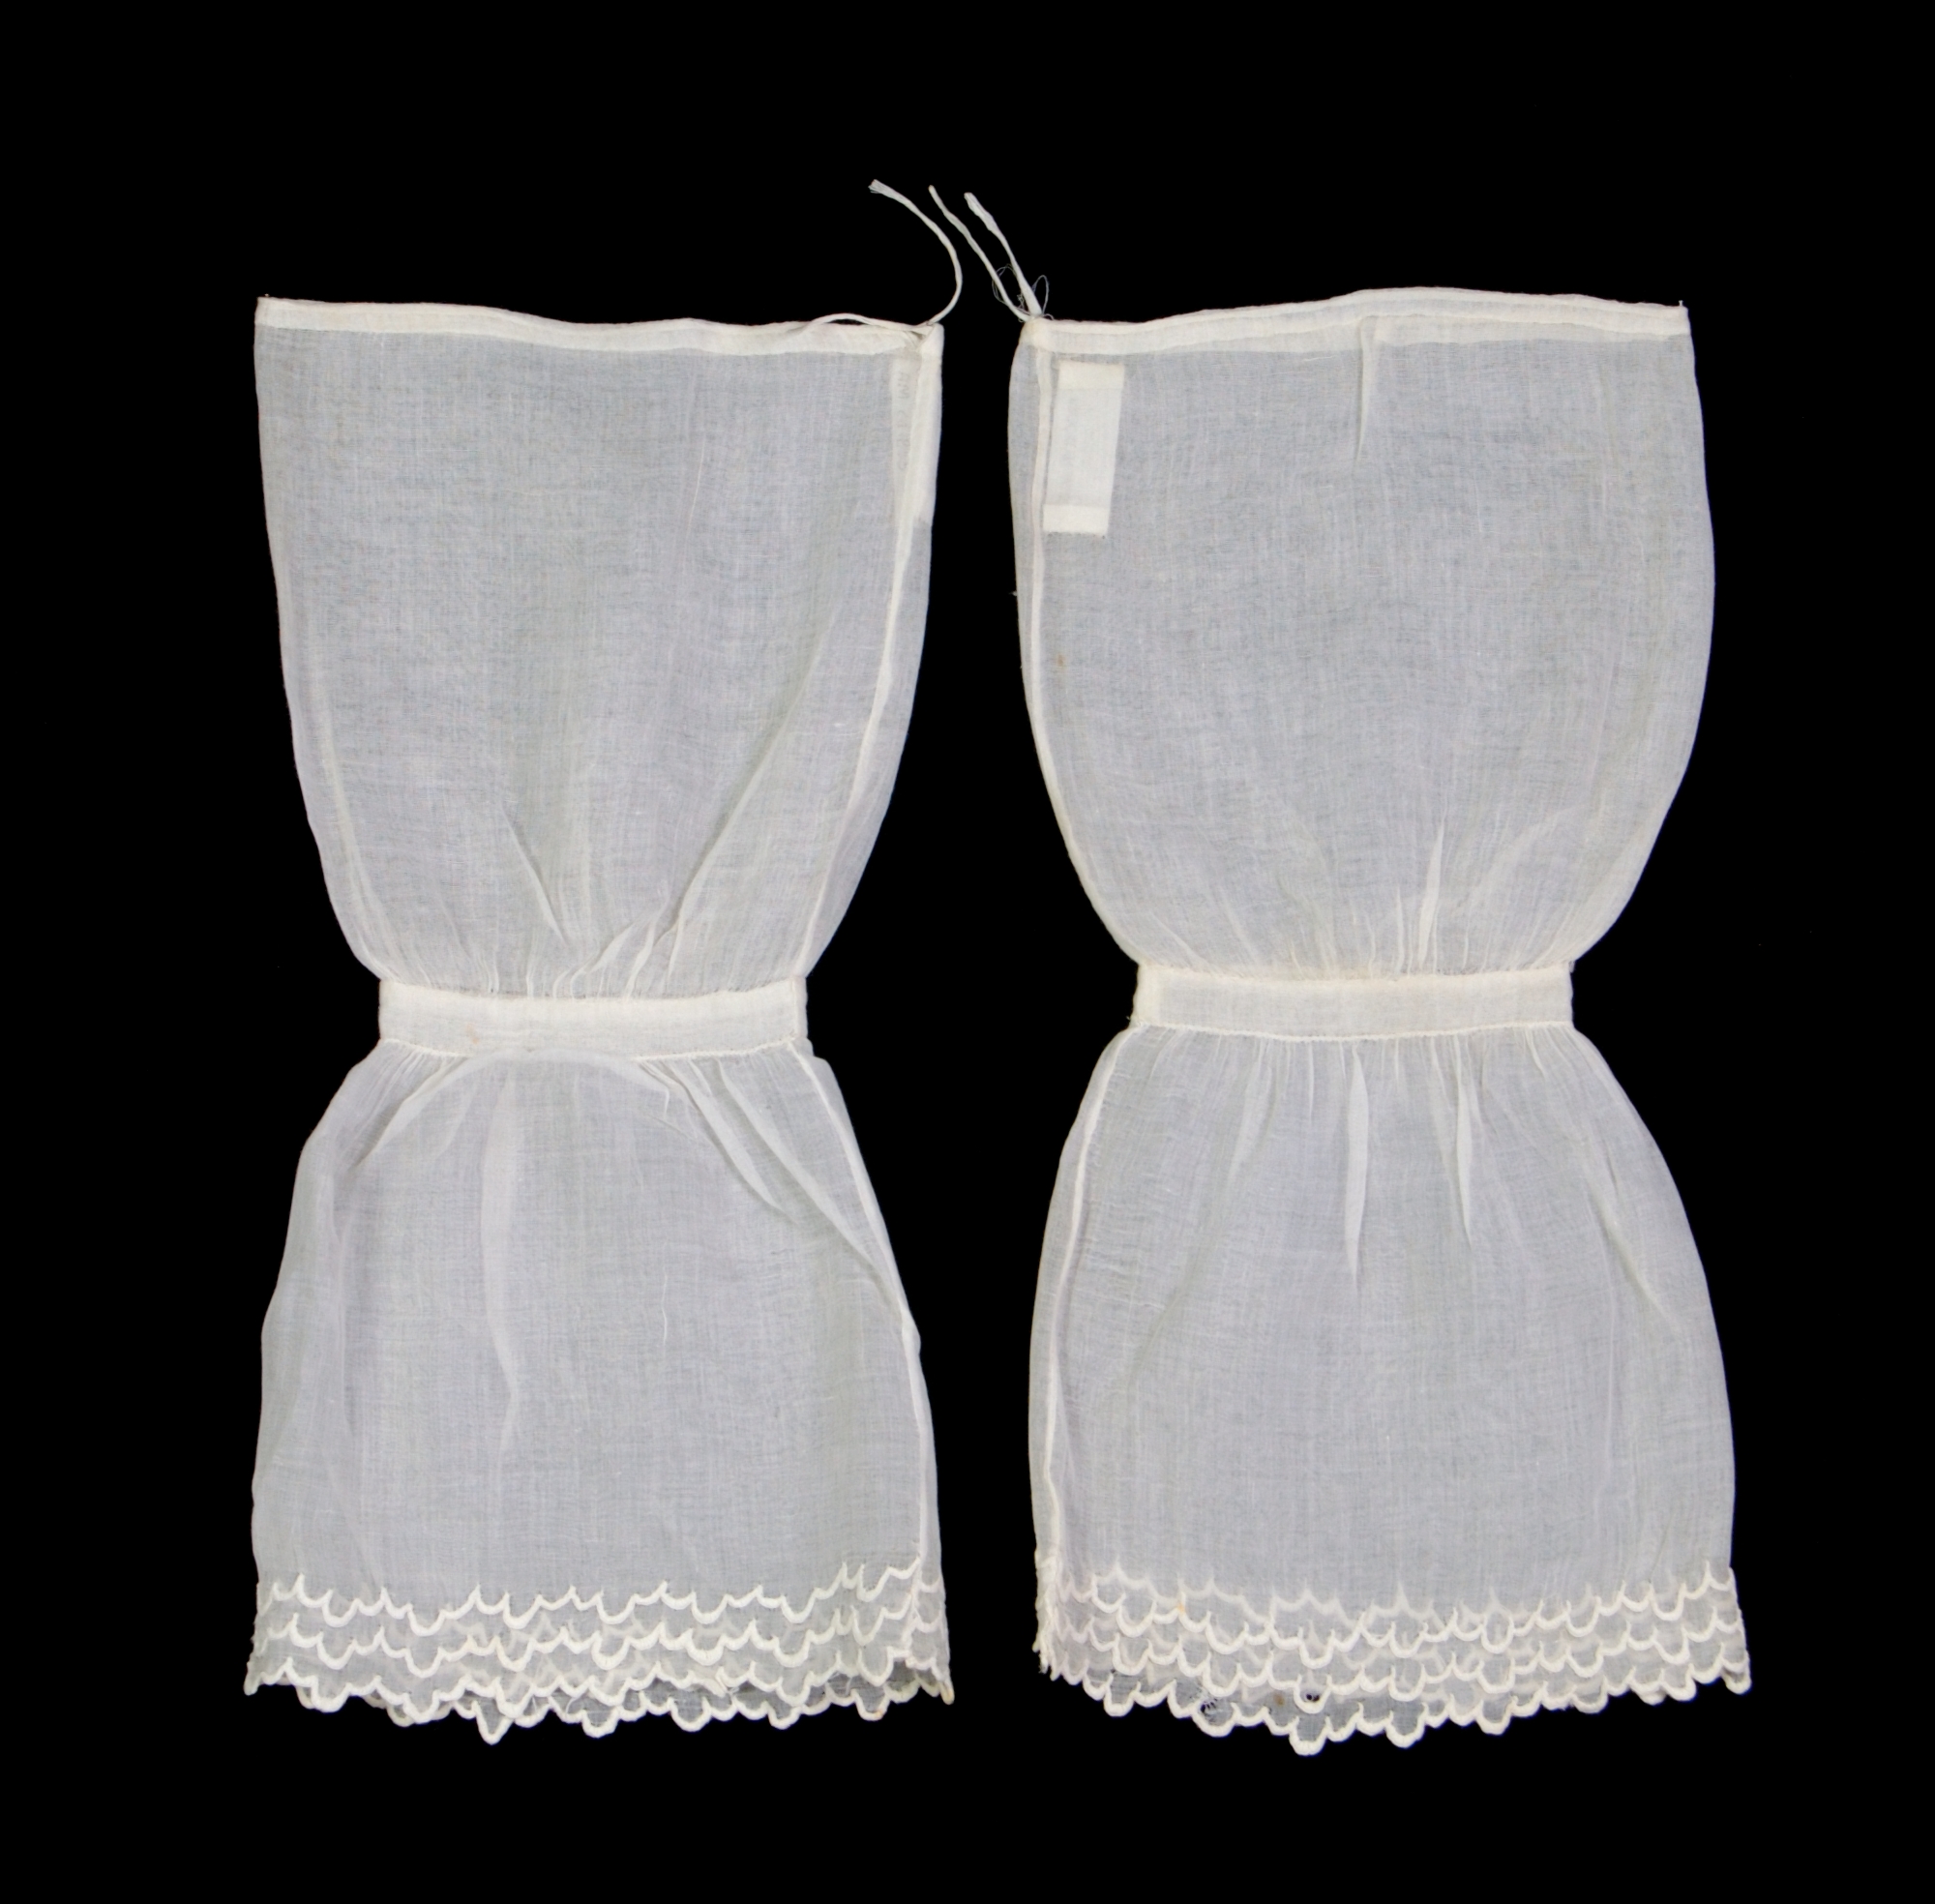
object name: undersleeves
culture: american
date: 1855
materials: cotton